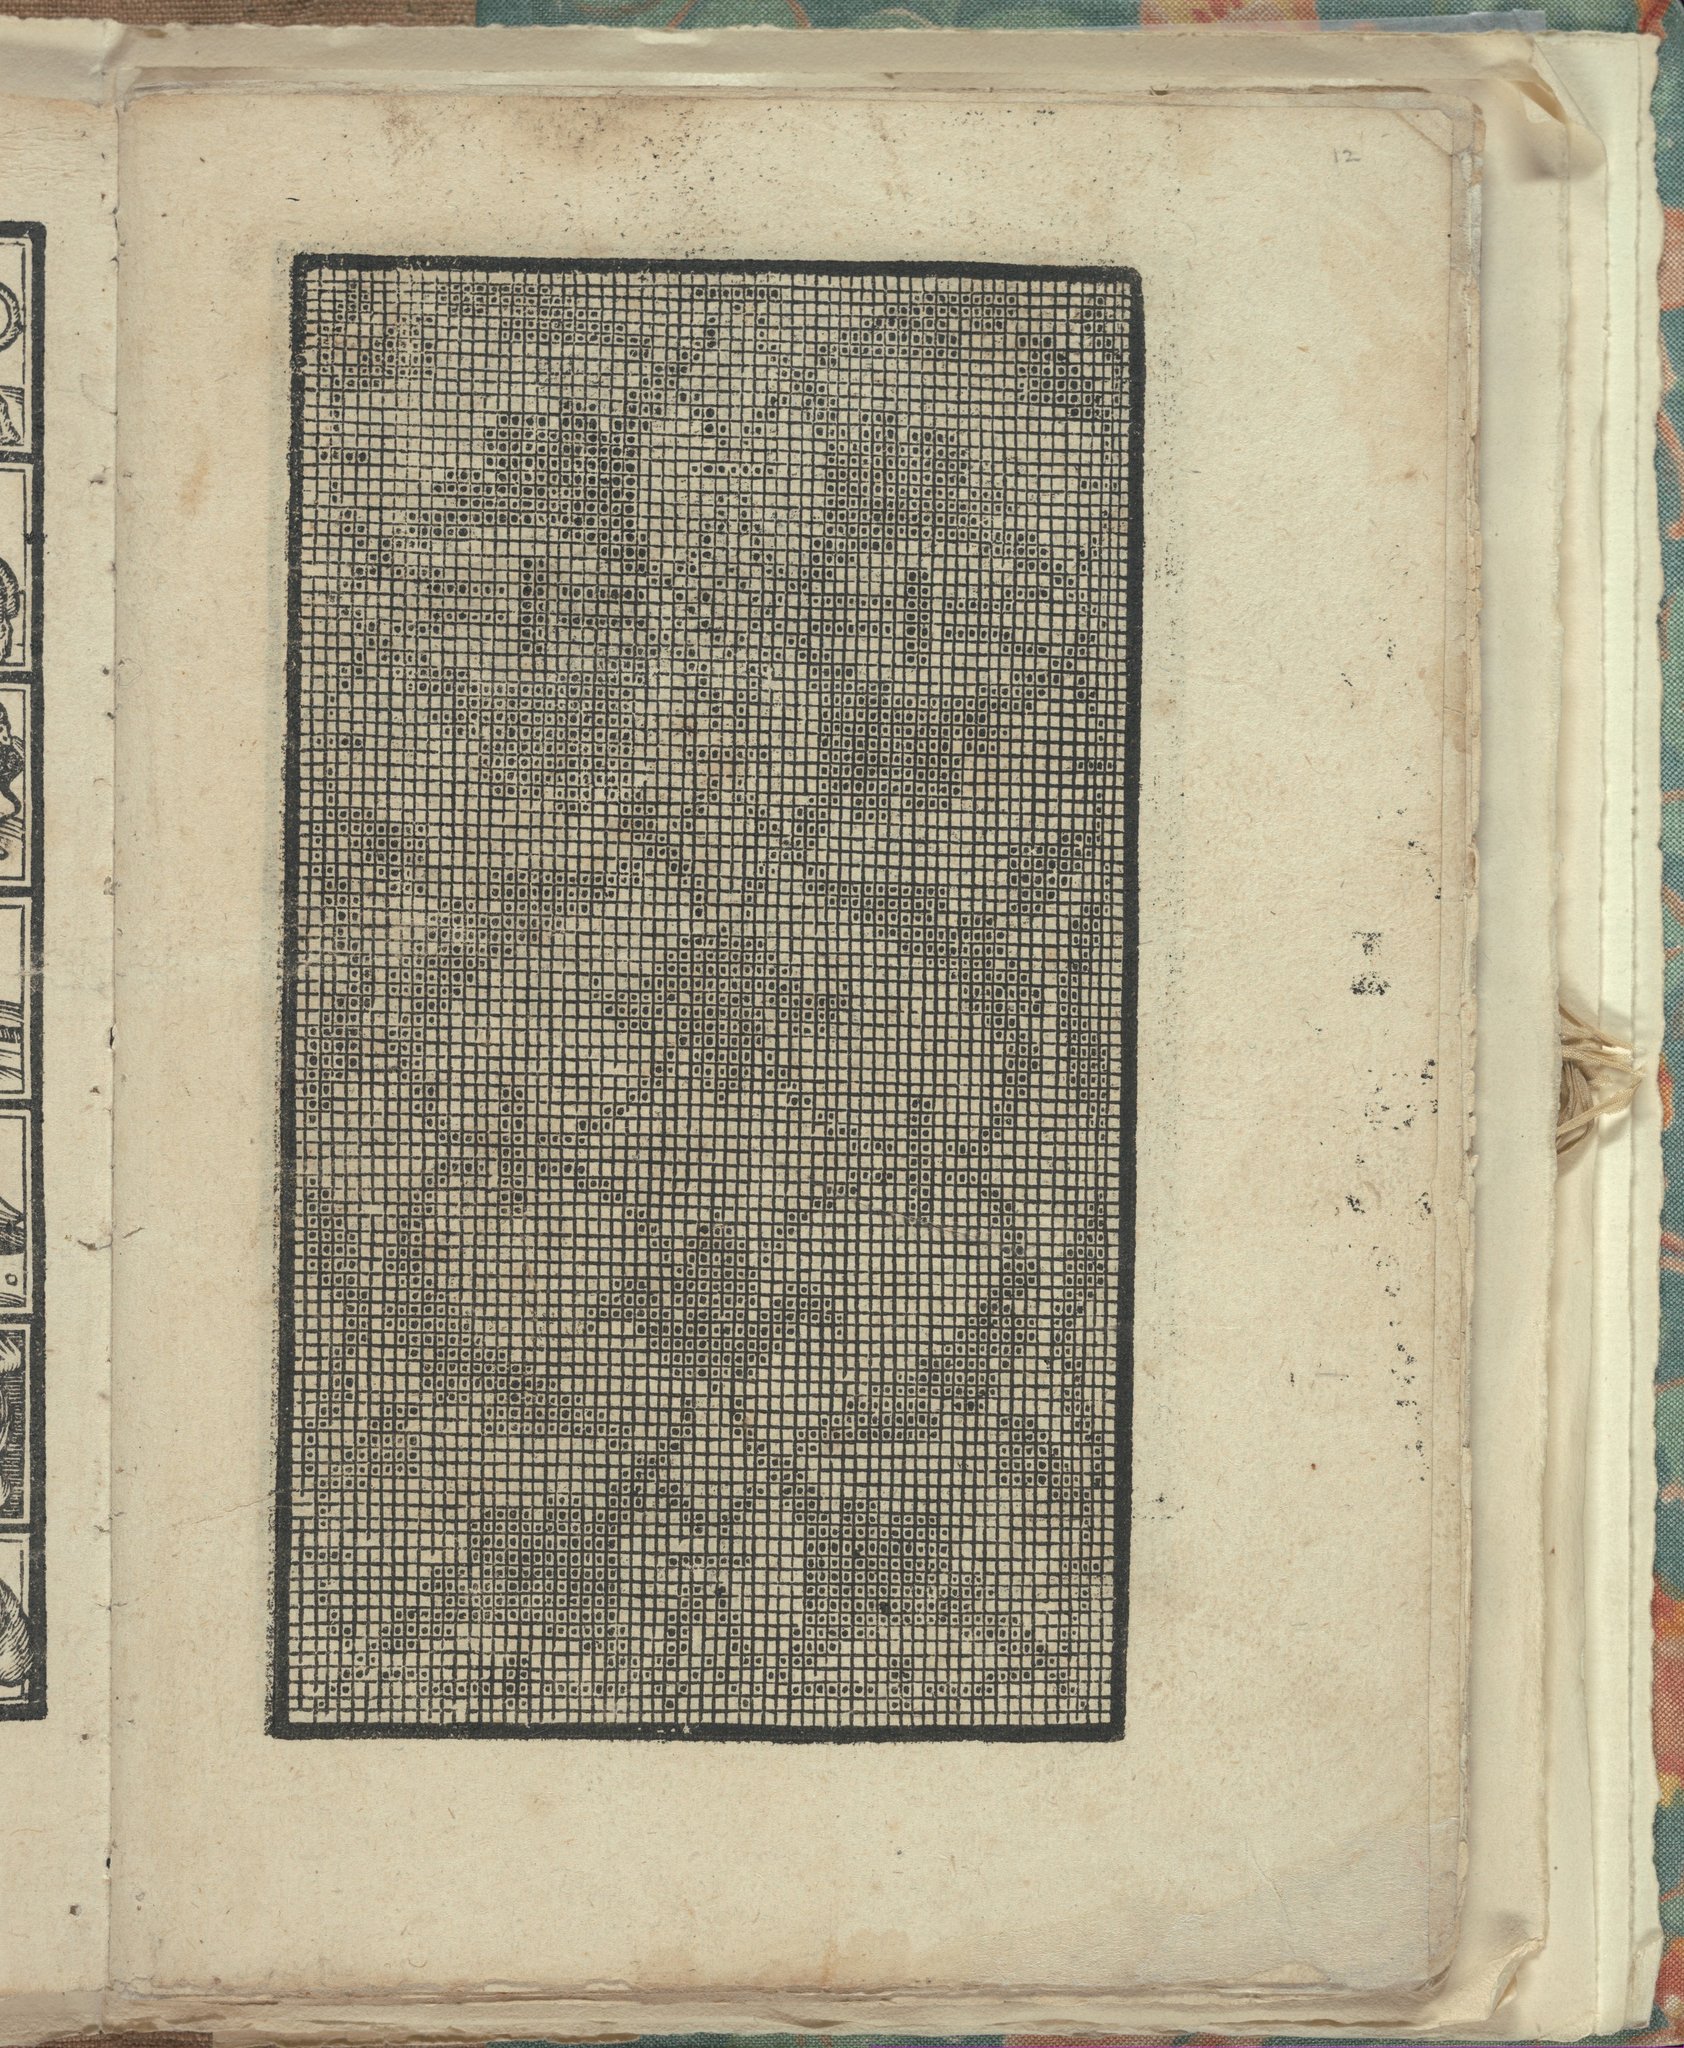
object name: book print ornament architecture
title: Opera Nova Universali intitulata Corona di racammi, page 12 (recto)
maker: giovanni andrea vavassore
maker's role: publisher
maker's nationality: italian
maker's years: 1530-1573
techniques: woodcut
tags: ornament